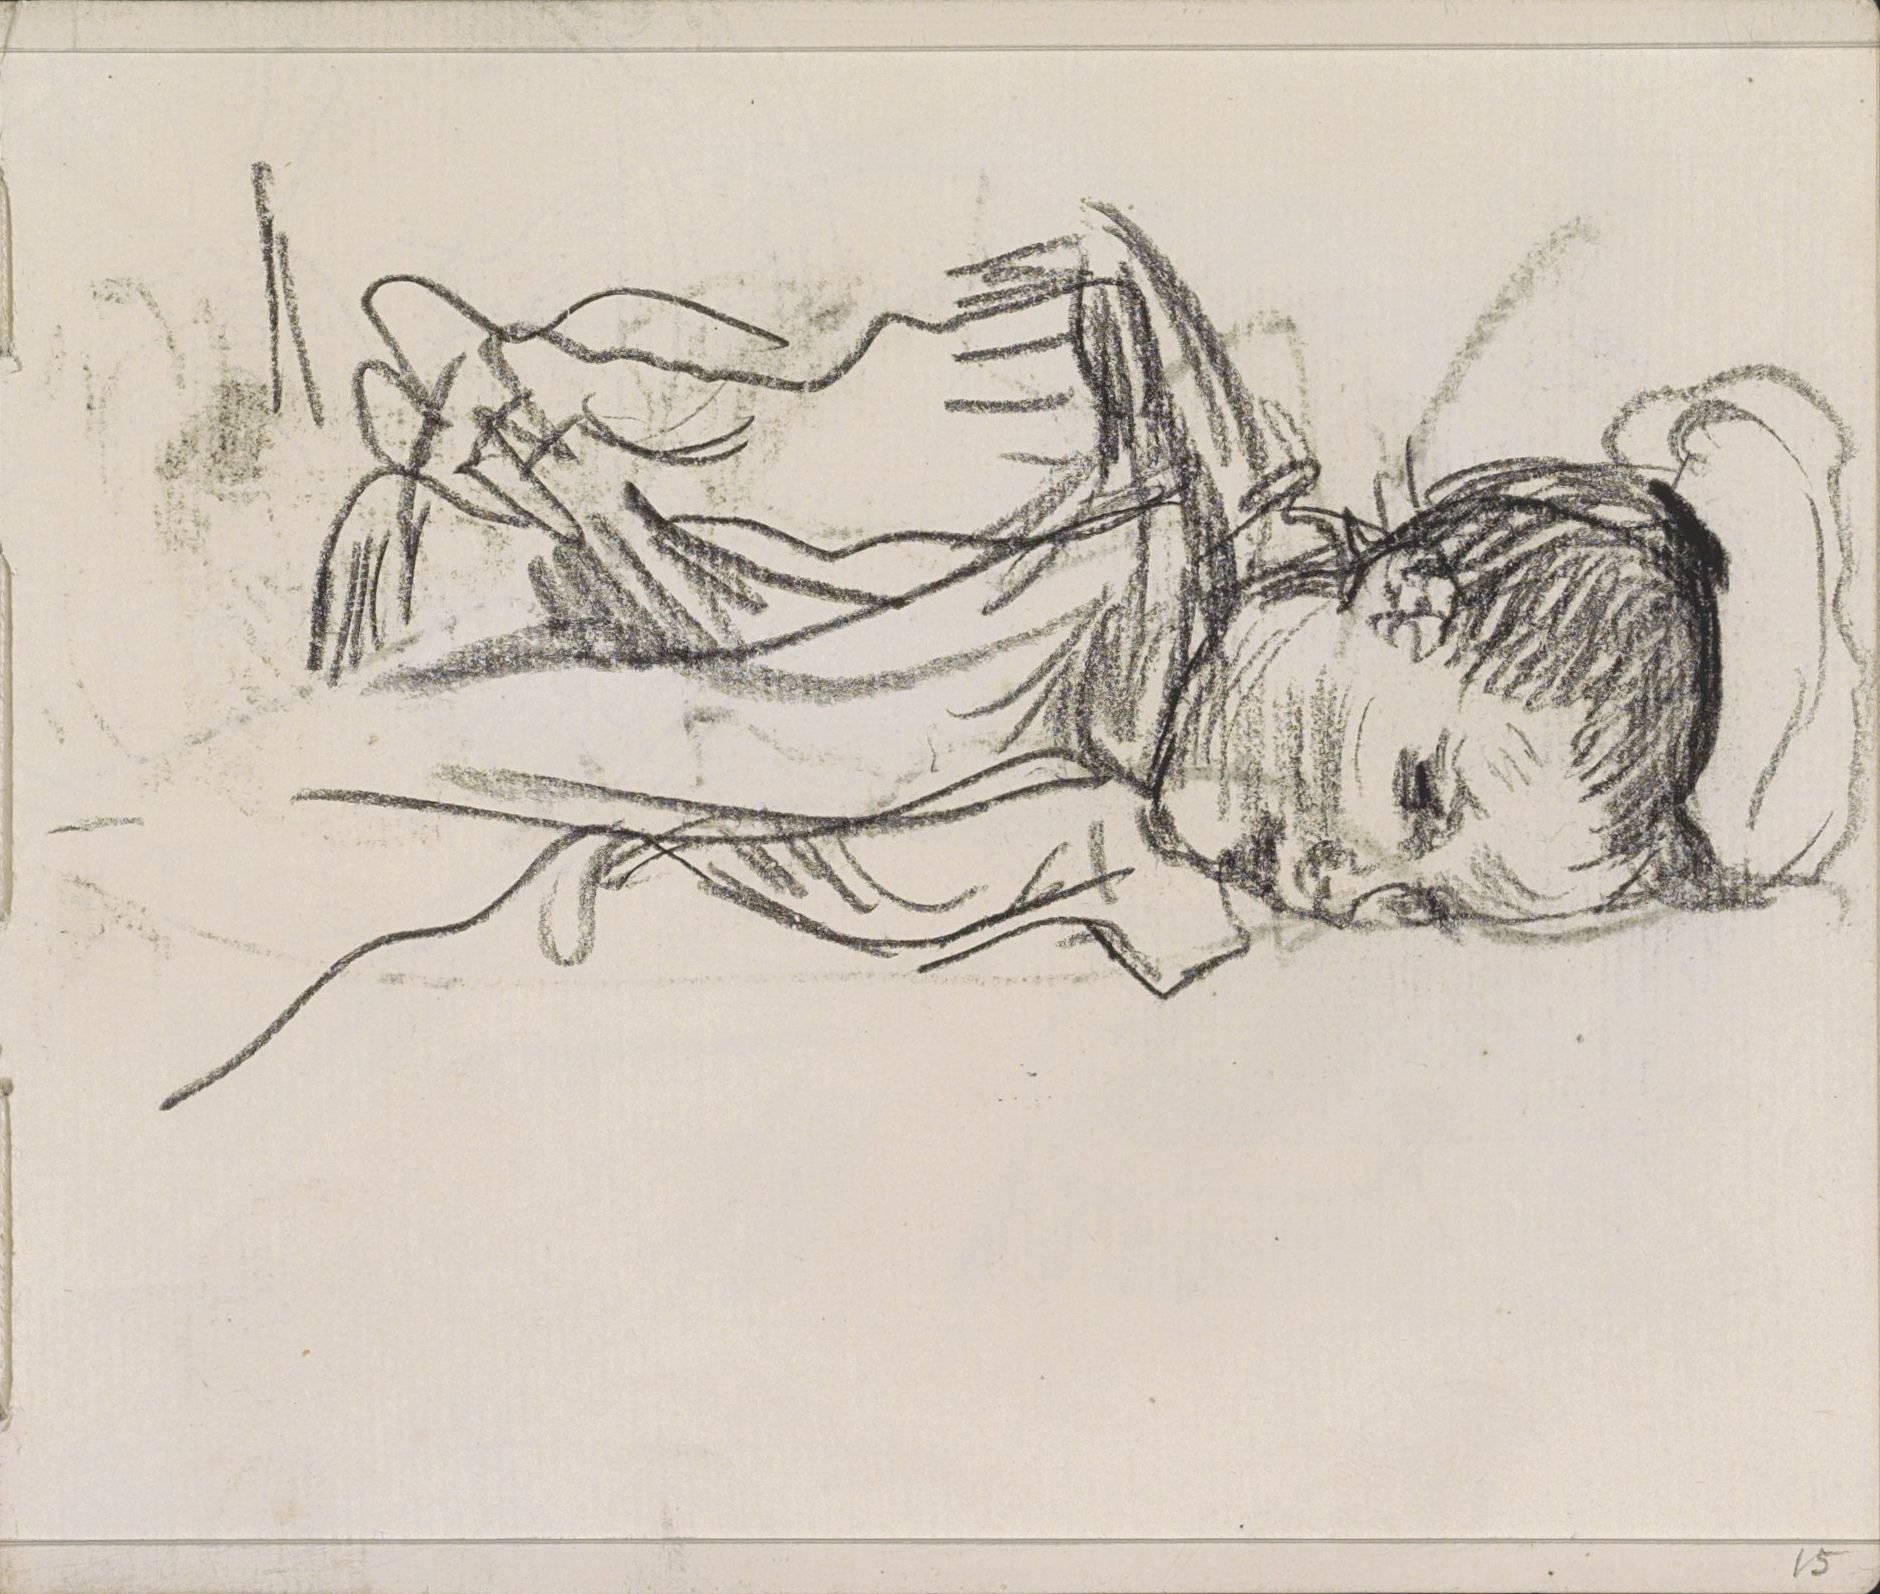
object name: sketchbook leaf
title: Dienstmeid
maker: isaac israels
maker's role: draughtsman, painter, print maker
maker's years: 1865-1934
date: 1886-1934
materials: chalk, paper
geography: amsterdam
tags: maid ~ house personnel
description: Blad 15 recto uit schetsboek LIV met 18 bladen.